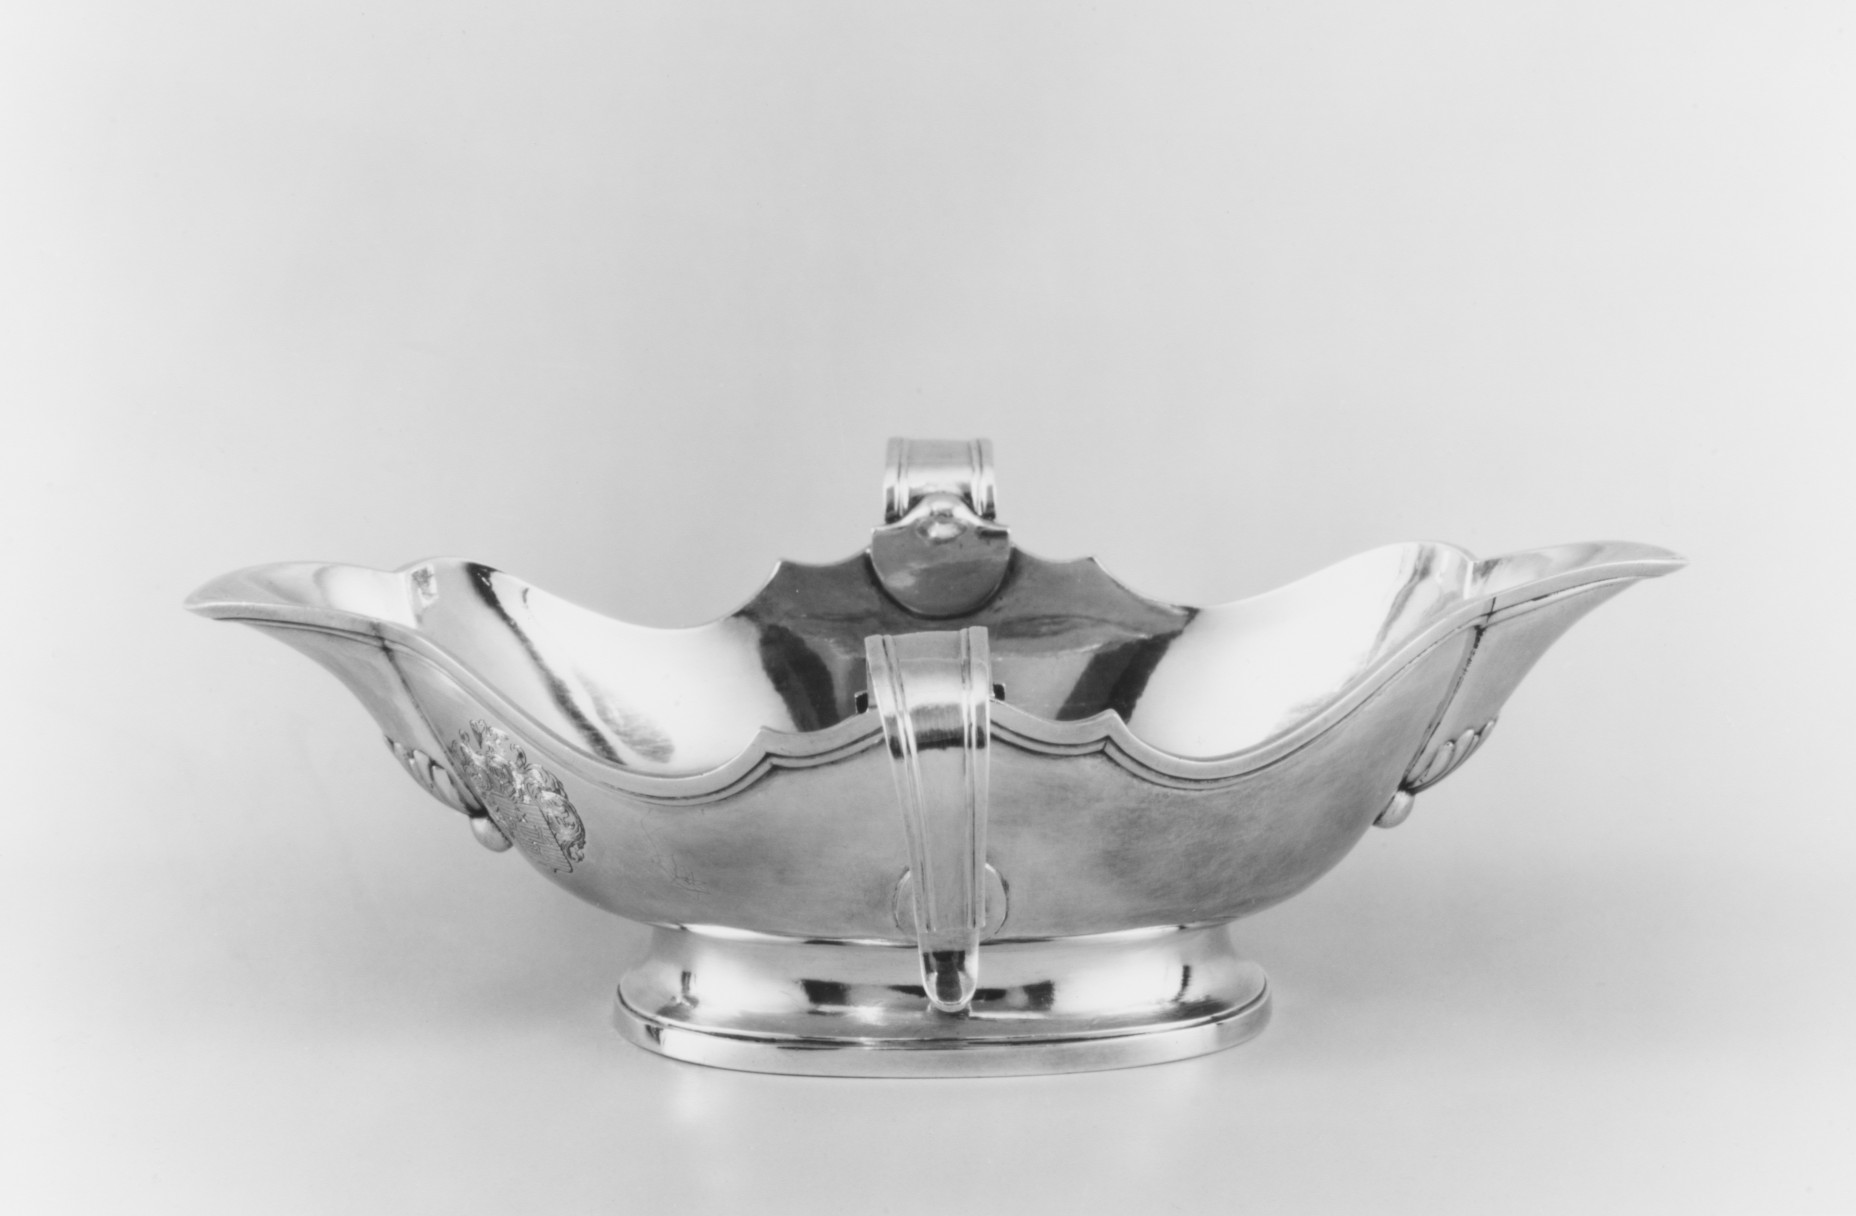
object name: sauceboat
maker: paul-david bazille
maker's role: maker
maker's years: 1740-1793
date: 1773-1774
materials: silver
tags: coat of arms